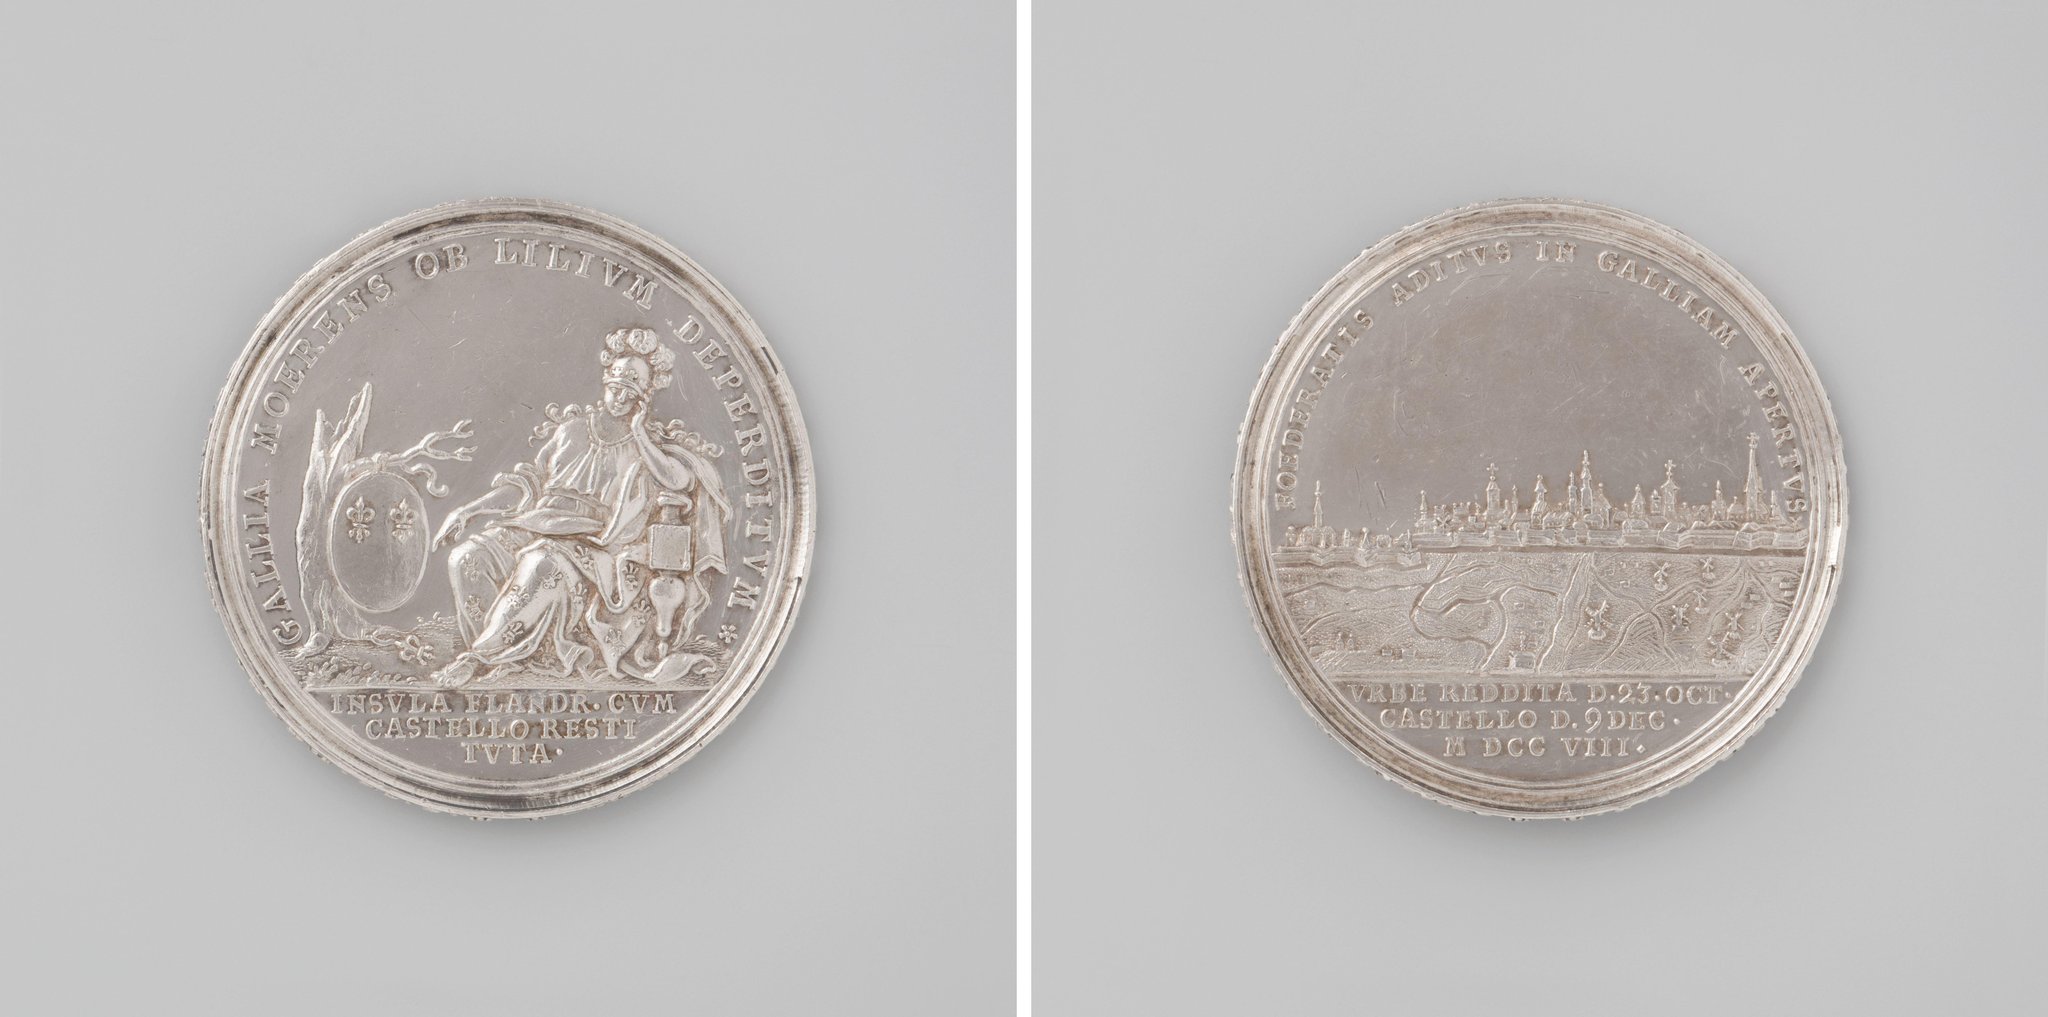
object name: history medal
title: Inname van de citadel van Rijssel door de bondgenoten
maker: martin brunner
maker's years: 1659-1725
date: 1708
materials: silver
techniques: striking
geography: nuremberg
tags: london, anna stuart (koningin van engeland en schotland), lille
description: Zilveren penning. Voorzijde: Gallia, in gedaante van treurende vrouw zittend op troon naast omgehakte boom waaraan Frans wapenschild hangt, waarvan een lelie is afgevallen binnen omschrift, boven opschrift. Keerzijde: gezicht op Rijssel binnen omschrift, boven opschrift; randschrift